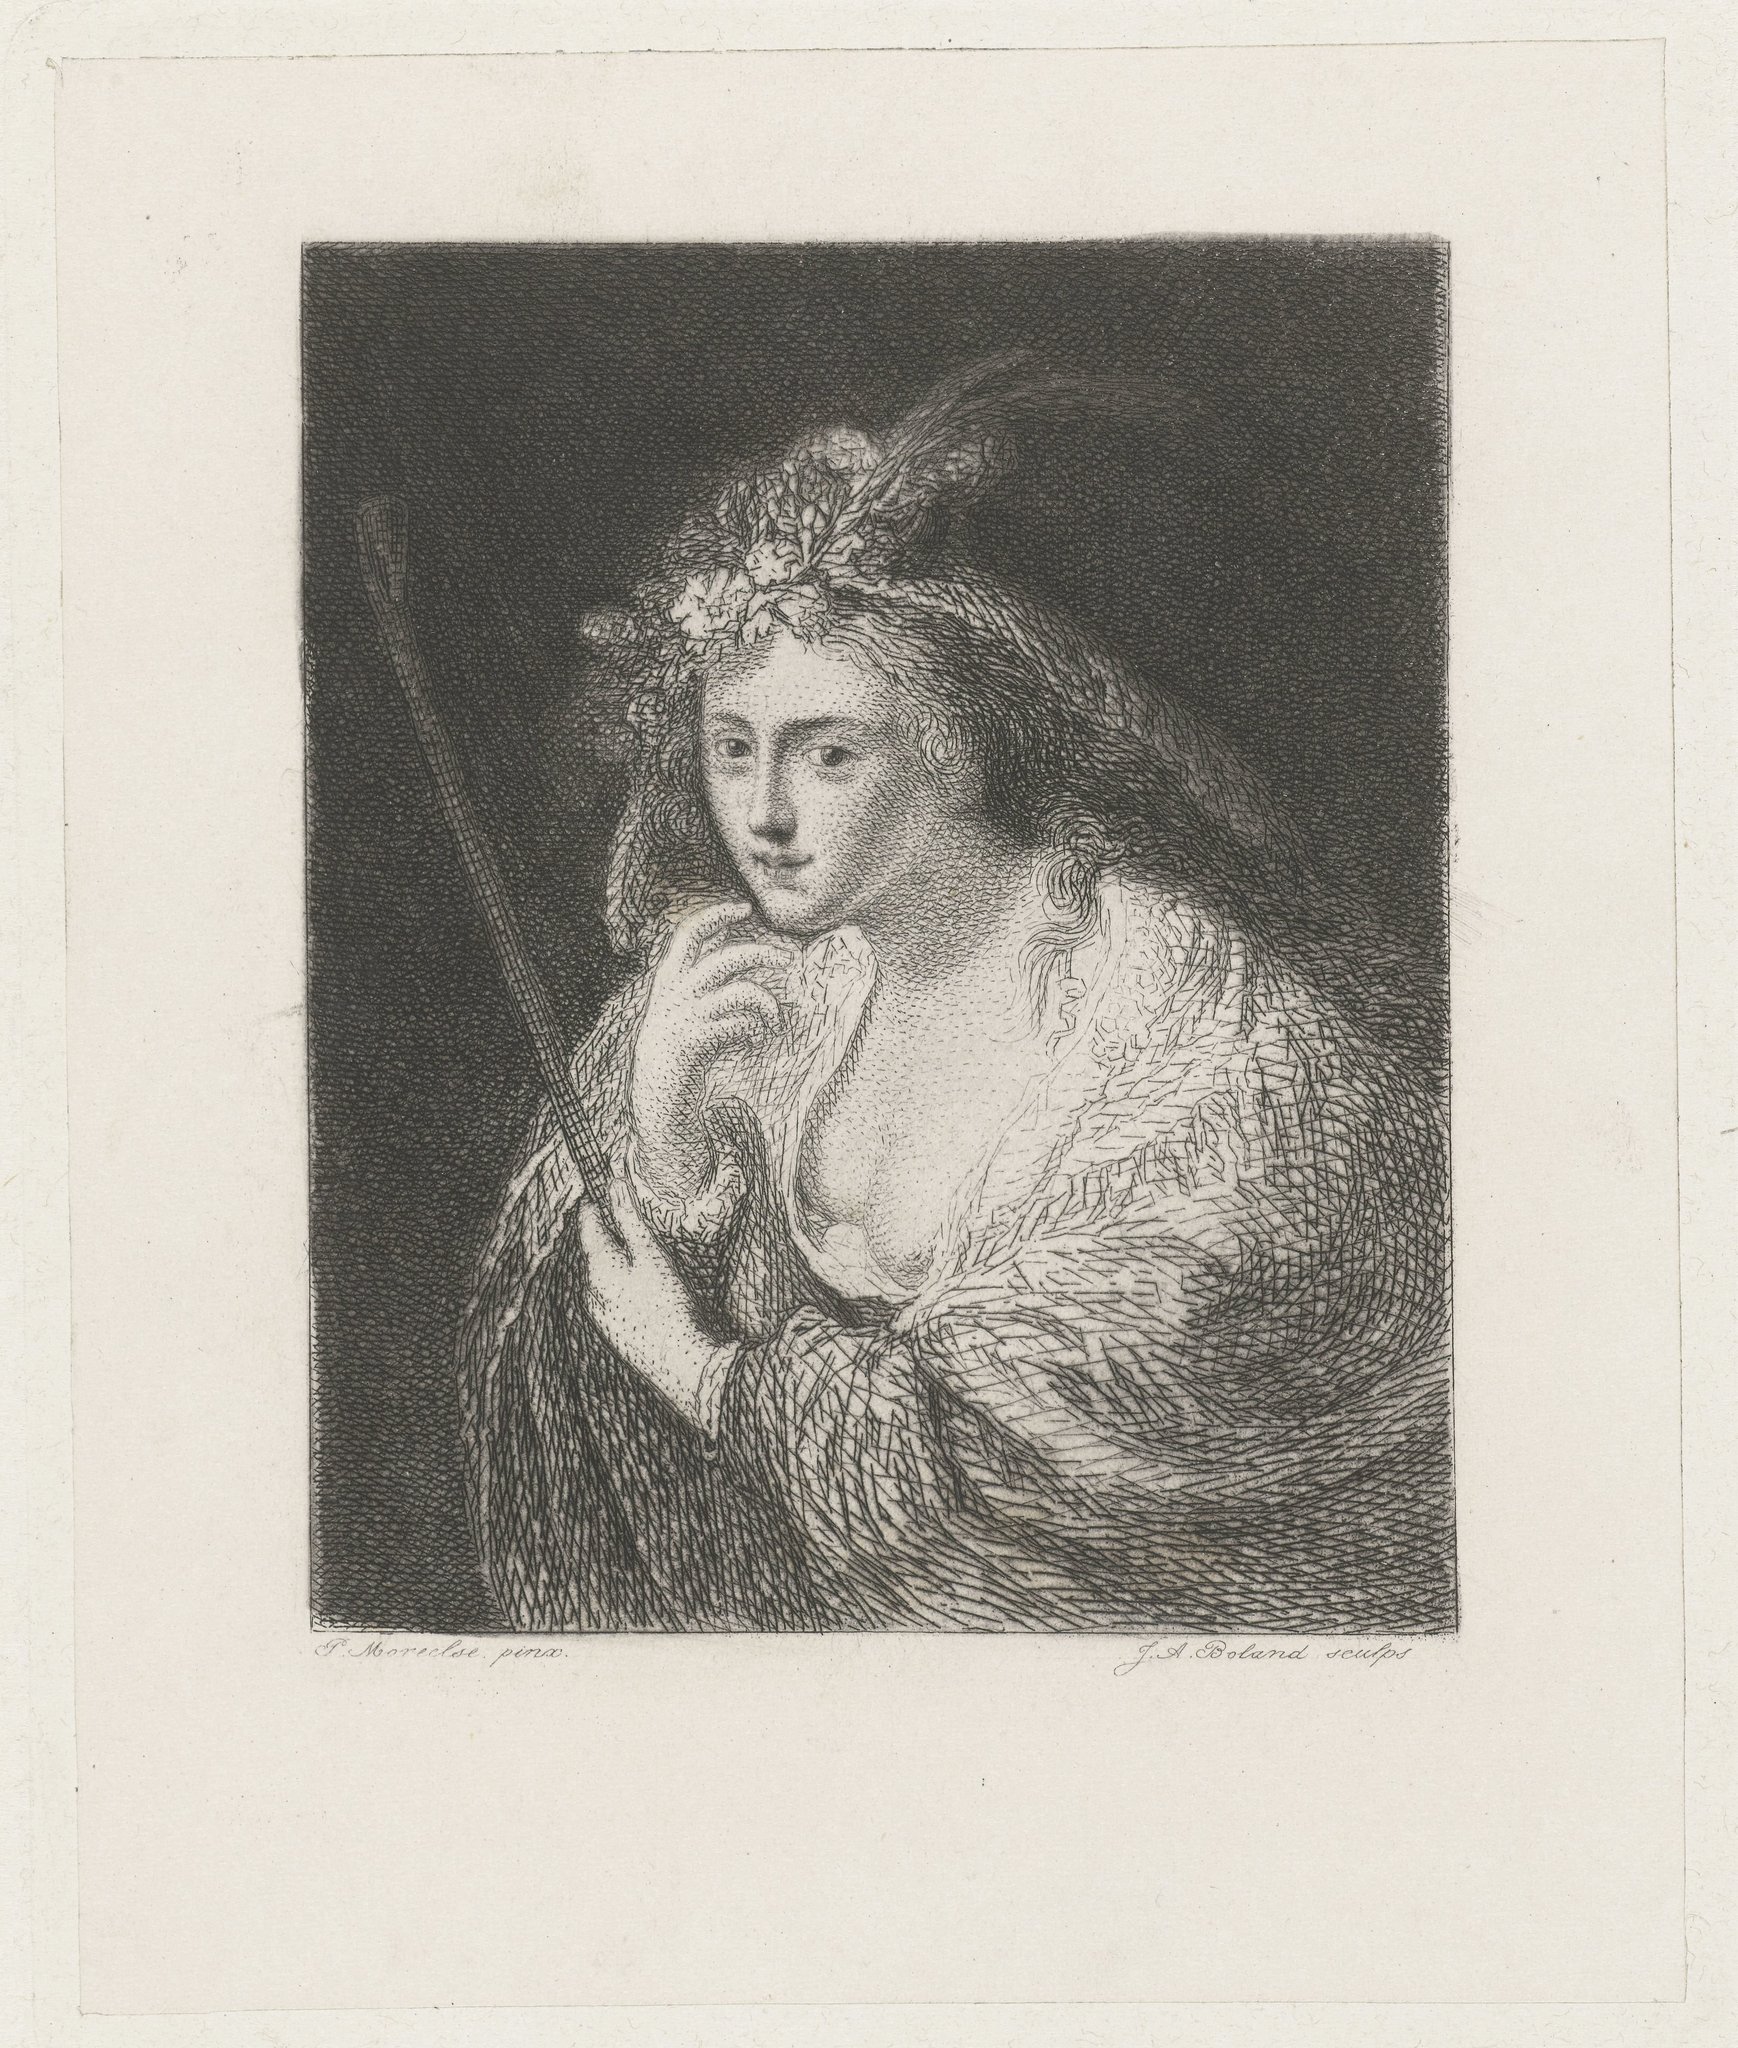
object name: print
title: De schone herderin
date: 1875-1876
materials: paper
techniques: etching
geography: amsterdam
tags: herding, herdsman, herdswoman, shepherd, shepherdess, cowherd, etc.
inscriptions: collector's mark: Lugt 2228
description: Reproductie van een schilderij uit de collectie van het Rijksmuseum Amsterdam, SK-A-276. Prent afkomstig uit: Brink, J. ten (et al.). Het Rijksmuseum te Amsterdam: [25] etsen van J.A. Boland. Haarlem: J.M. Schalekamp, [1875-1876] (13 A 20).